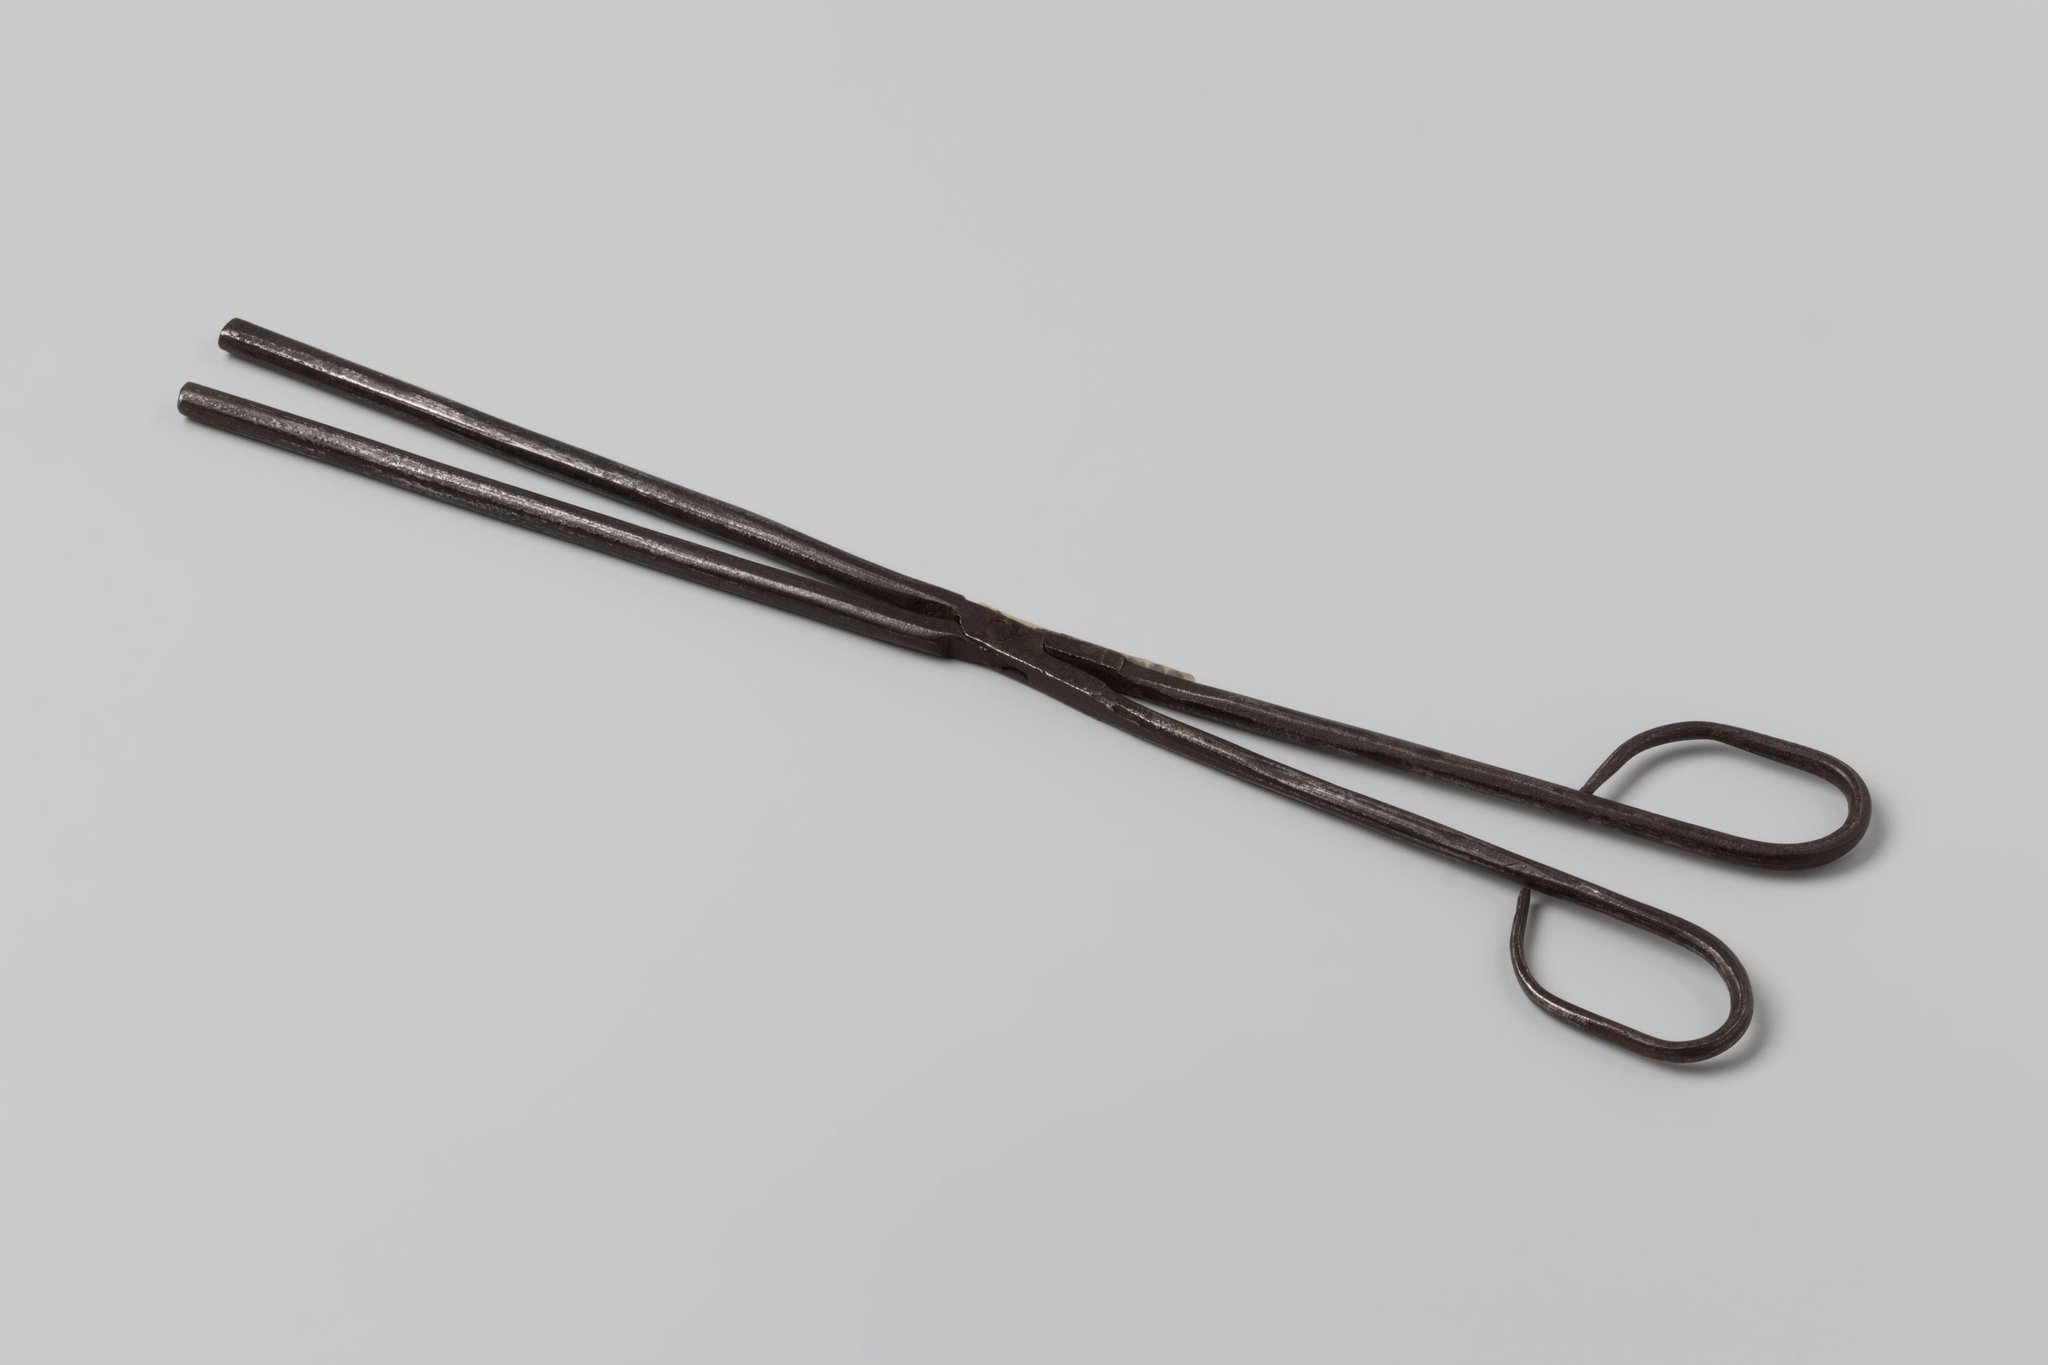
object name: neepjesmuts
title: Neepjesmutstang van ijzer, in het model van een schaar, voor de plooien in een neepmuts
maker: Anonymous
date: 1800-1900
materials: iron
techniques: forging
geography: netherlands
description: Een neepjesmutstang van ijzer. In het model van een schaar met rechthoekige gebogen ogen en twee dikke rolronde, stomp beëindigende tangen.